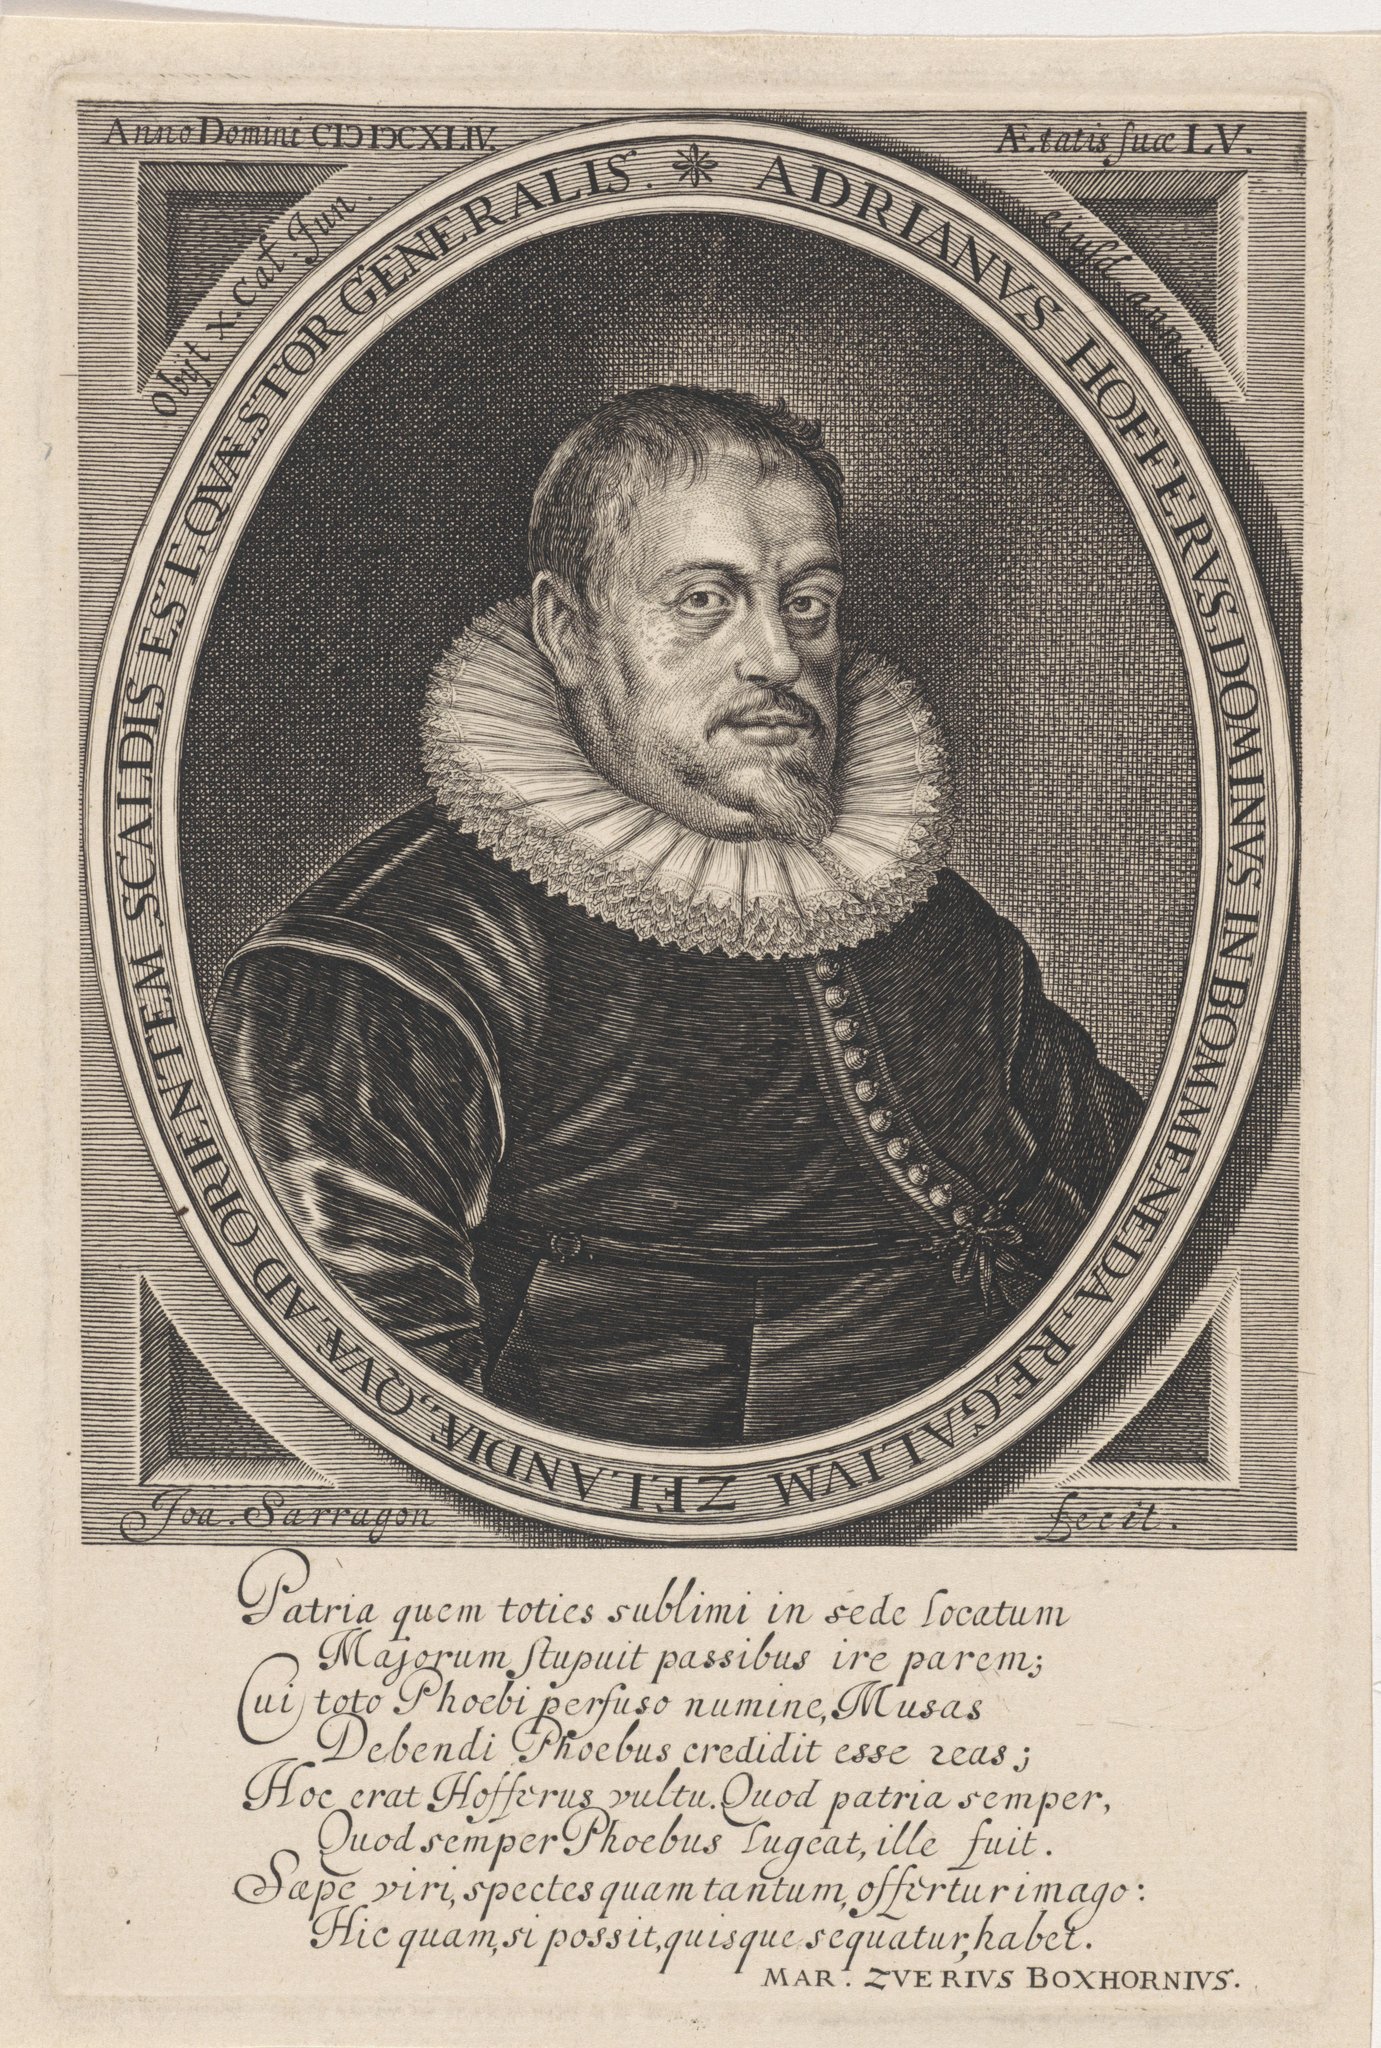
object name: print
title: Portret van Adriaan Hoffer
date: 1644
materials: paper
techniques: engraving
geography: middelburg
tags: adriaan hoffer, historical persons, portrait of a writer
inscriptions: collector's mark: Lugt 2228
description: De prent is ook als boekillustratie gebruikt in: Meertens, P.J. Letterkundig leven in Zeeland in de zestiende en de eerste helft der zeventiende eeuw, Amsterdam: N.V. Noord-Hollandsche Uitgevers Maatschappij, 1943.